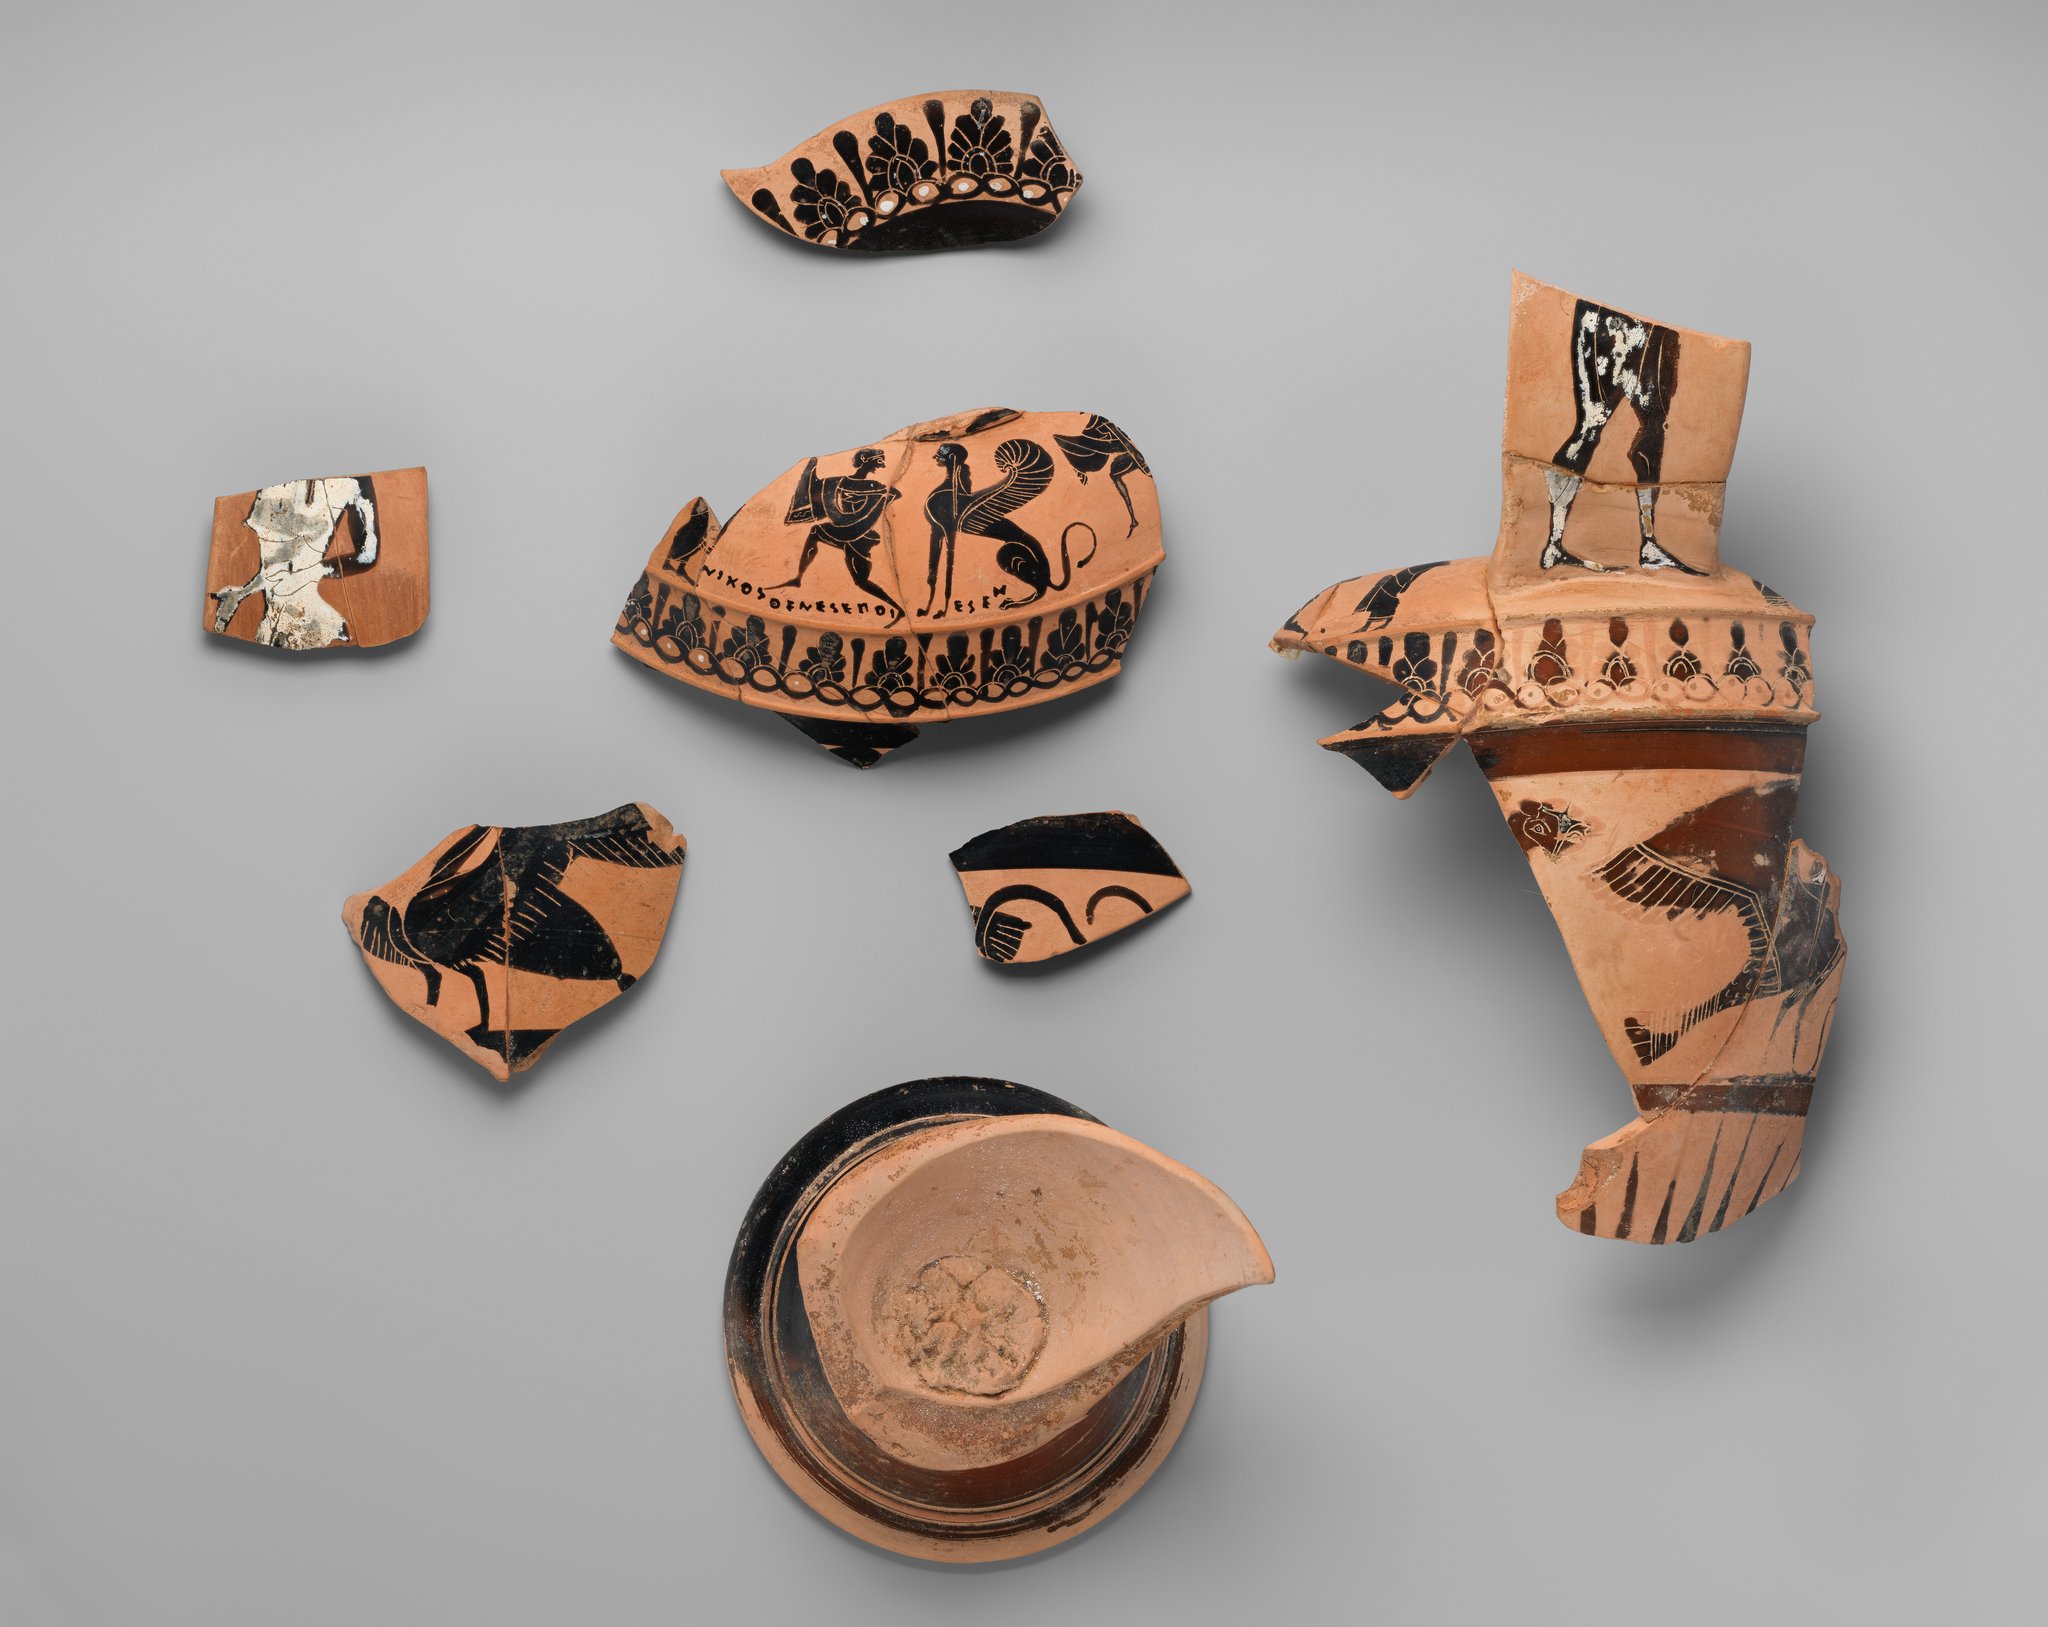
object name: neck amphora, fragmentary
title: Terracotta fragmentary neck-amphora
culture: greek, attic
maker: nikosthenes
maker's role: artist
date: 600-501 BCE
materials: terracotta